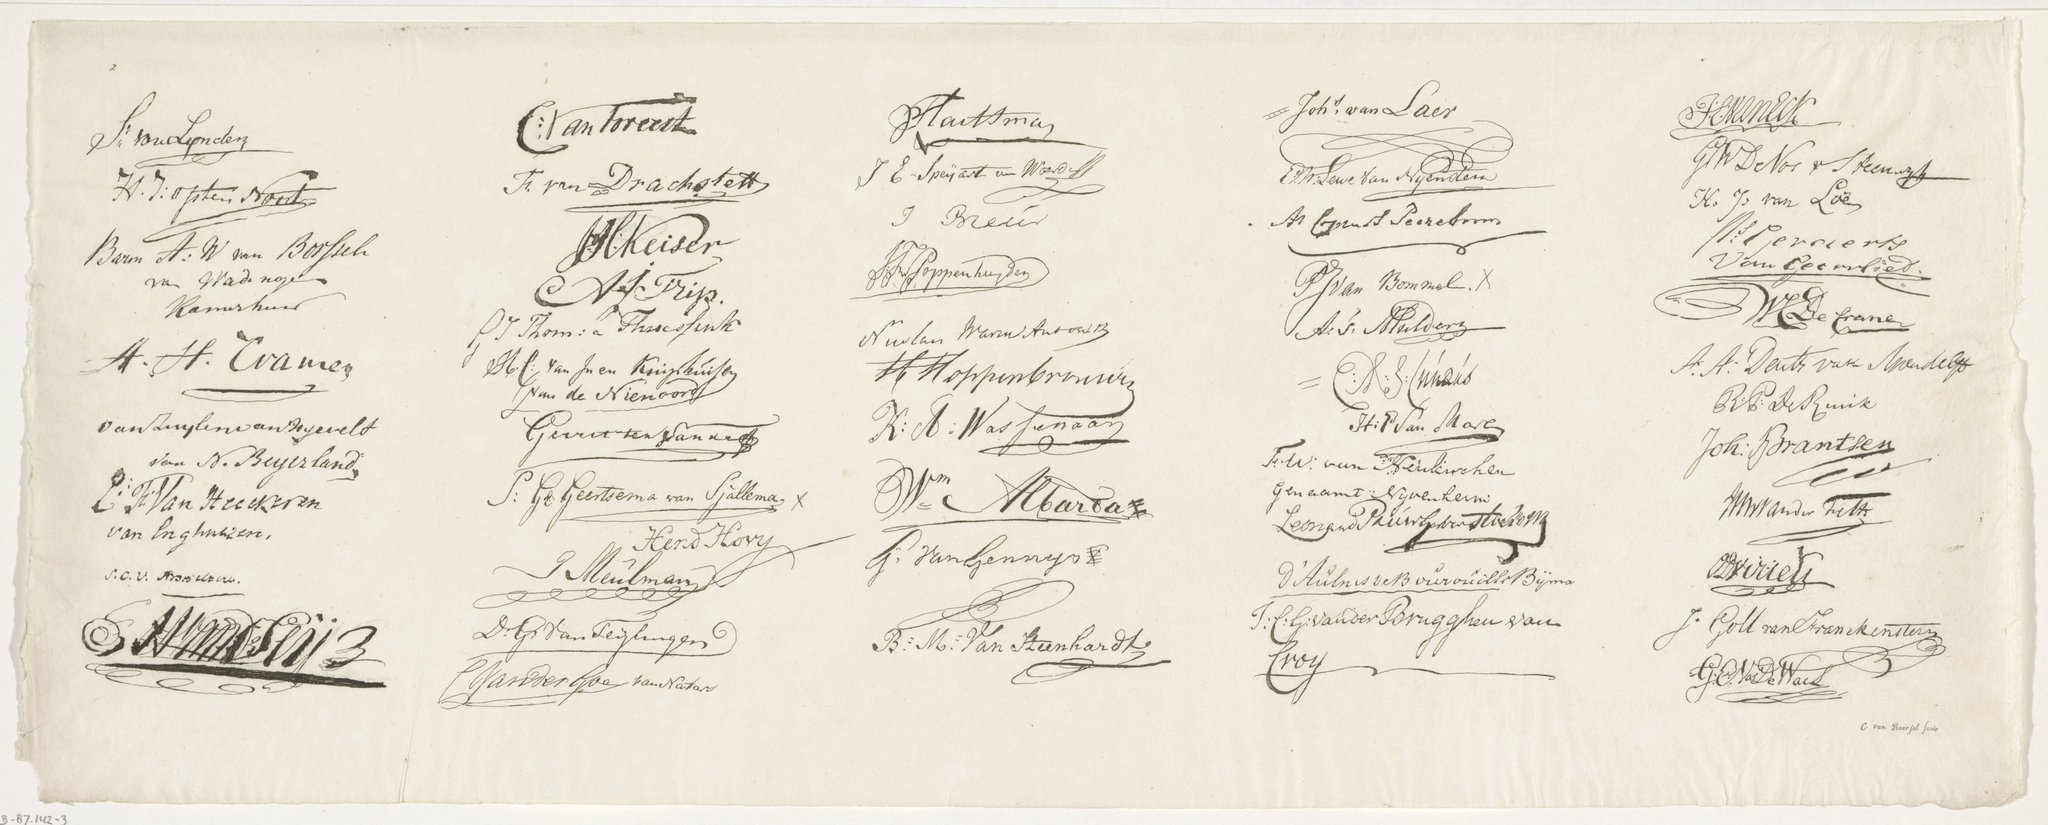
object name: print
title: Blad met handtekeningen van de leden van de Vergadering der Aanzienlijken, 1814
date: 1814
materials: paper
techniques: etching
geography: the hague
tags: the hague, berlin, william i of the netherlands, handwriting, written text, amsterdam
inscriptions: collector's mark: Lugt 2228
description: Blad nr. 2 uit de serie van negen bladen met in facsimile de handtekeningen van de leden van de Vergadering der Aanzienlijken bijeen ter onderhandeling over de nieuwe grondwet, te Amsterdam op 29 maart 1814.